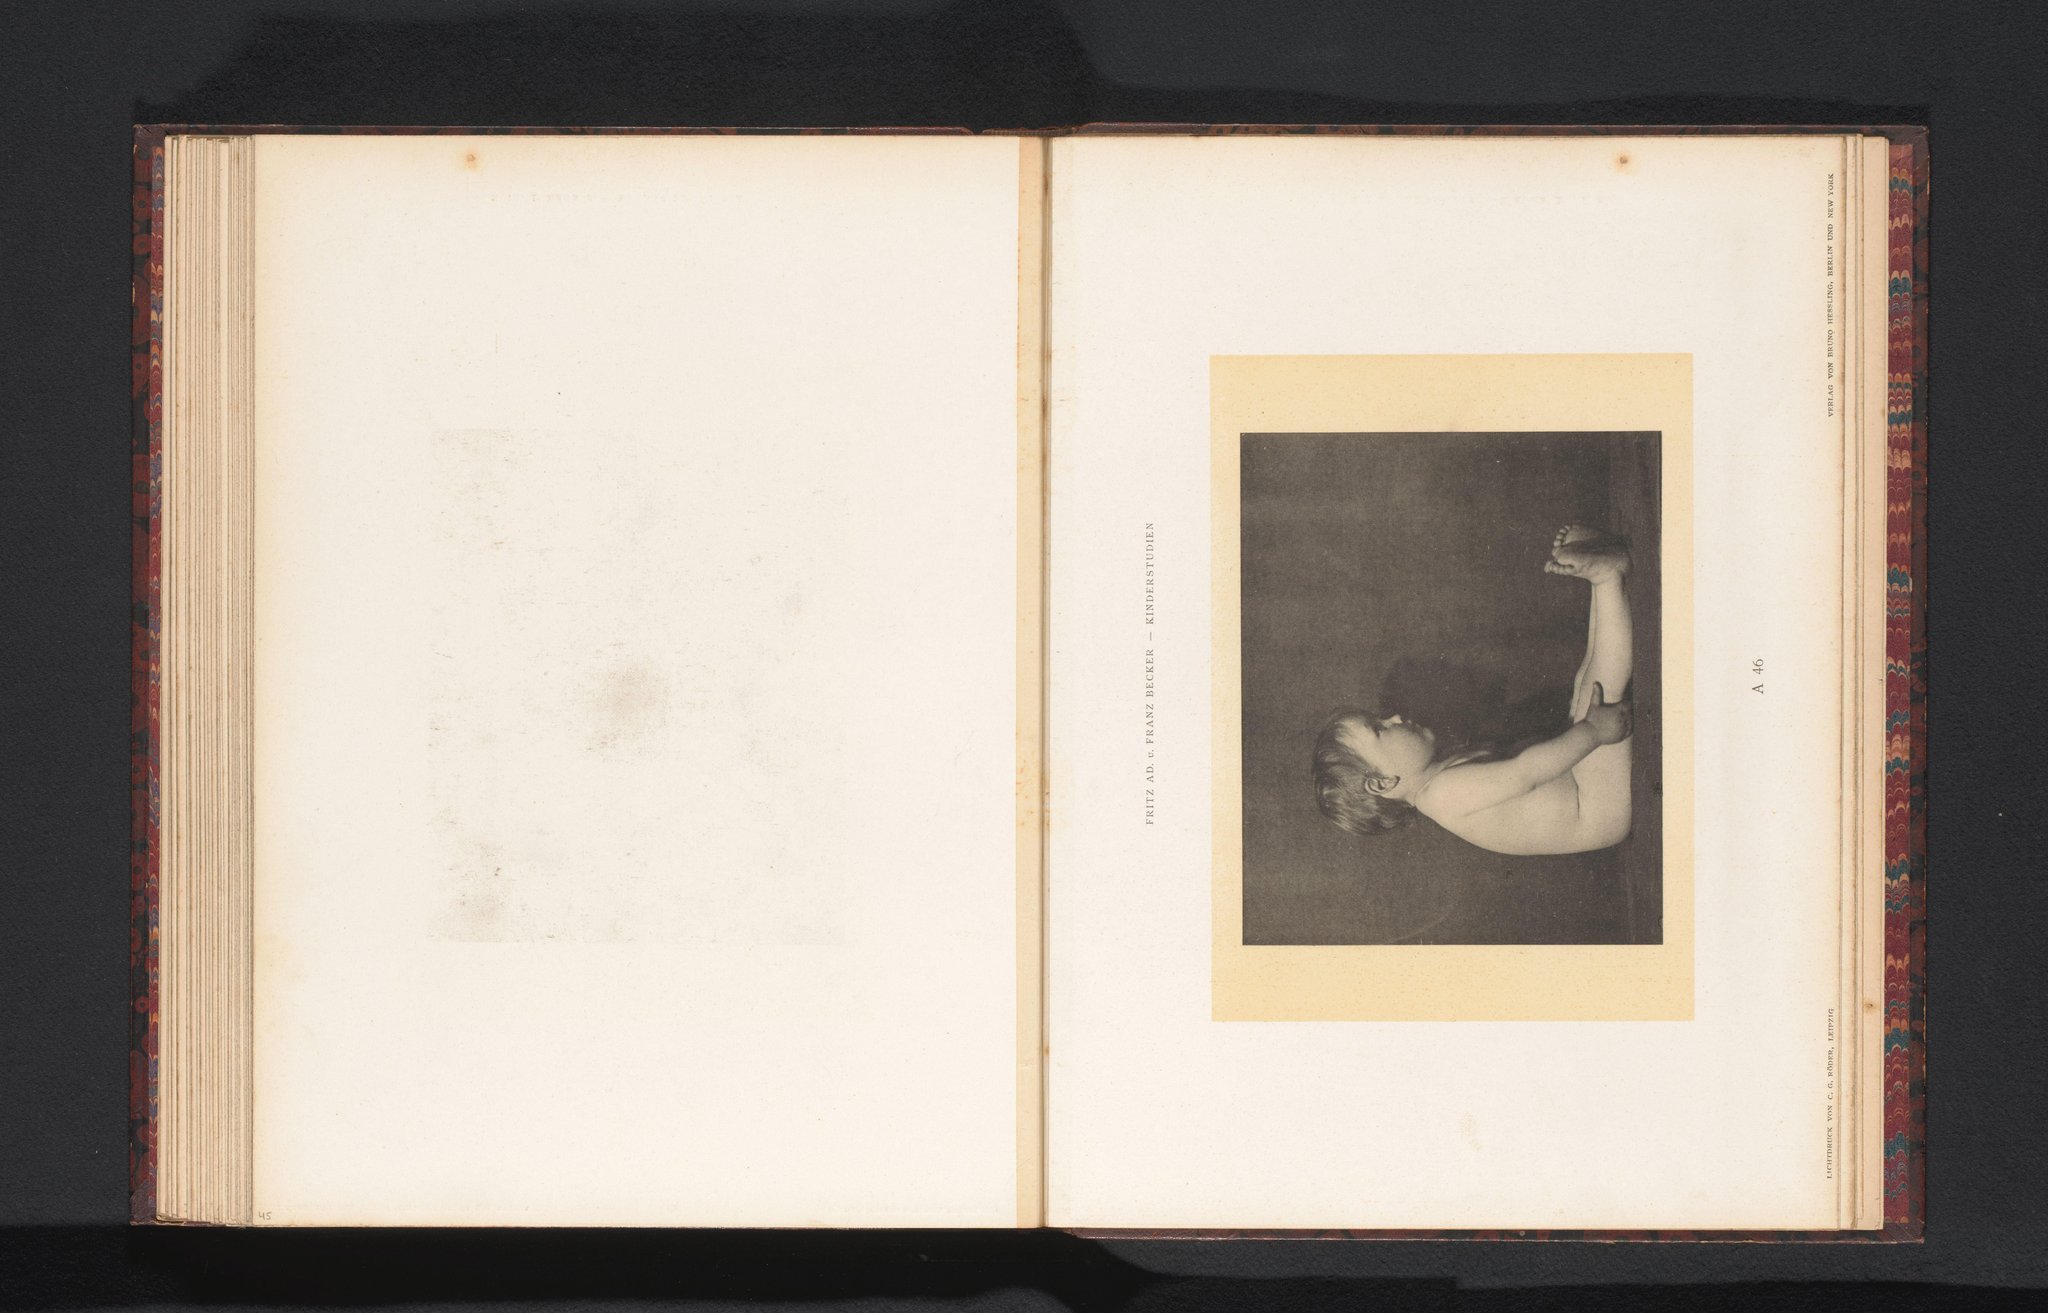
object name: photomechanical print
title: Zittend naakt kind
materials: paper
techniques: photograph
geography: leipzig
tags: sitting figure (+ right side visible; right - (r. hand, r. foot, etc.)), tot, toddler ~ the ages of man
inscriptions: number: ‘A 46’